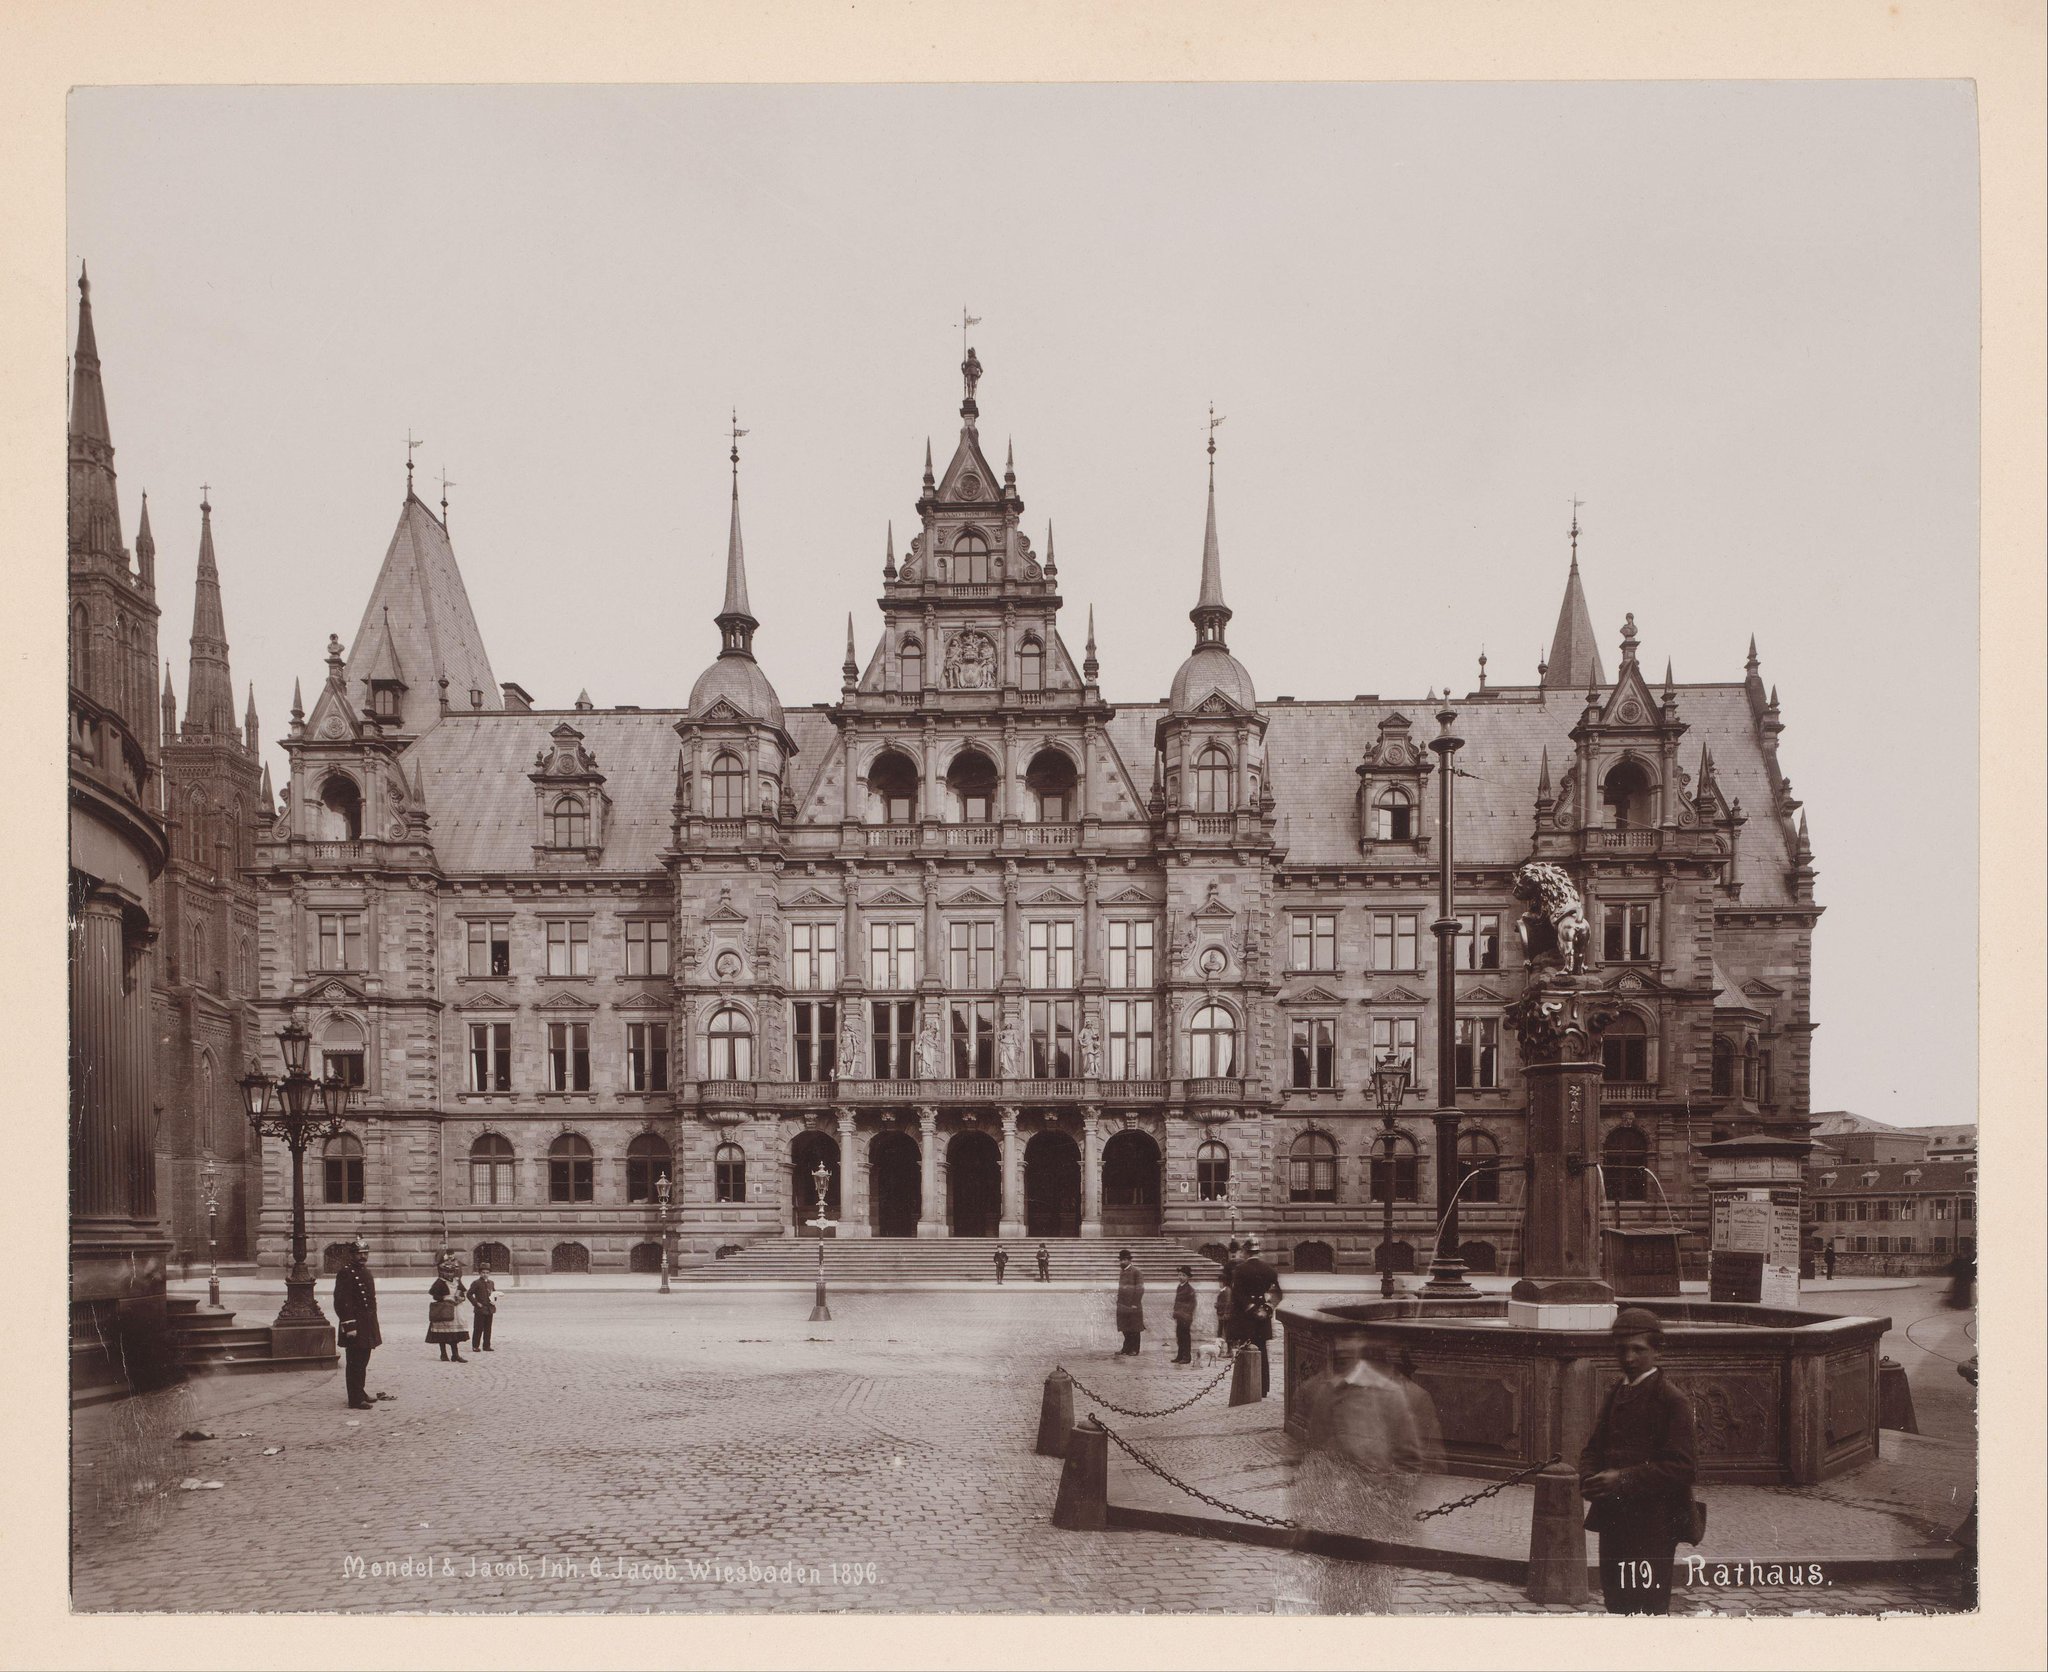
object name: photograph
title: Raadhuis, Wiesbaden, Duitsland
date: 1896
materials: cardboard, paper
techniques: collodion silver print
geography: wiesbaden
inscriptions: inscription: ‘Mondel & Jacob, Inh. G. Jacob, Wiesbaden, 1896.’, inscription: ‘119. Rathaus.’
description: Bijna frontaal aanzicht van het raadhuis in Wiesbaden, met een plein met fontein op de voorgrond, en enkele mensen.